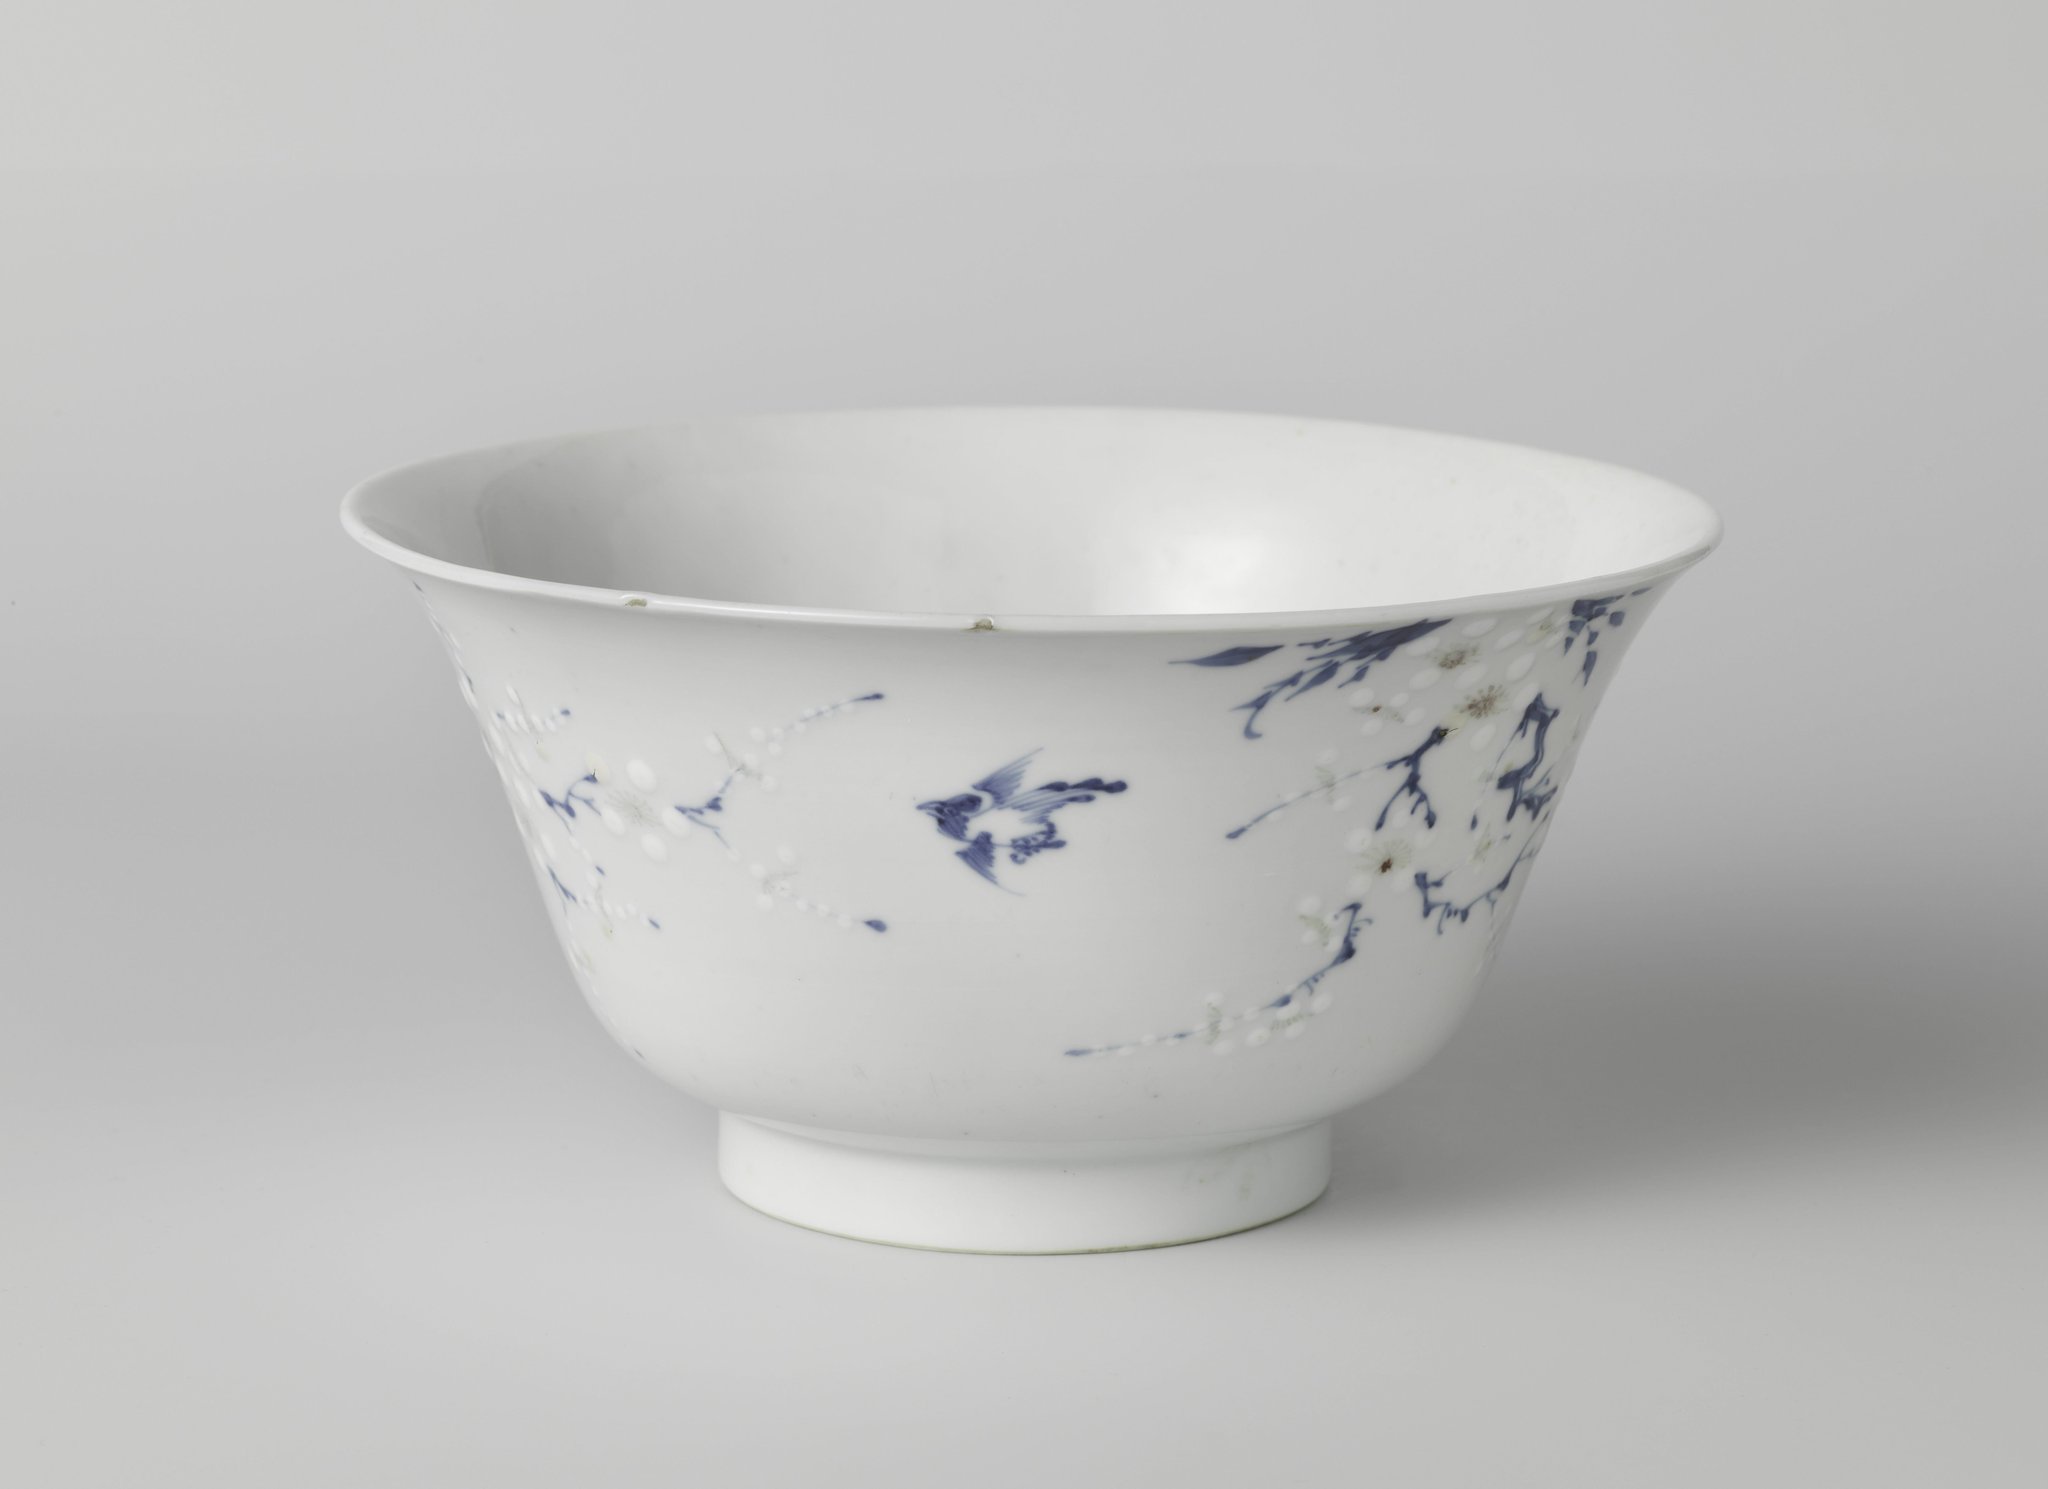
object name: bowl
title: Bowl with prunus sprays and birds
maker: Anonymous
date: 1680-1720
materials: cobalt, copper, glaze, paint, porcelain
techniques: firing, turning, vitrification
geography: china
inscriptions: mark: ‘制 Zhì’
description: Kom met spreidende wand van porselein, beschilderd in onderglazuur blauw en rood en witte slib. Op de wand prunustakken waartussen vliegende vogels; op de bodem een rots. Gemerkt op de onderzijde met het zegelmerk 'zhi' in een dubbele cirkel. Een chip in de rand. Onderglazuur blauw met koperrood.